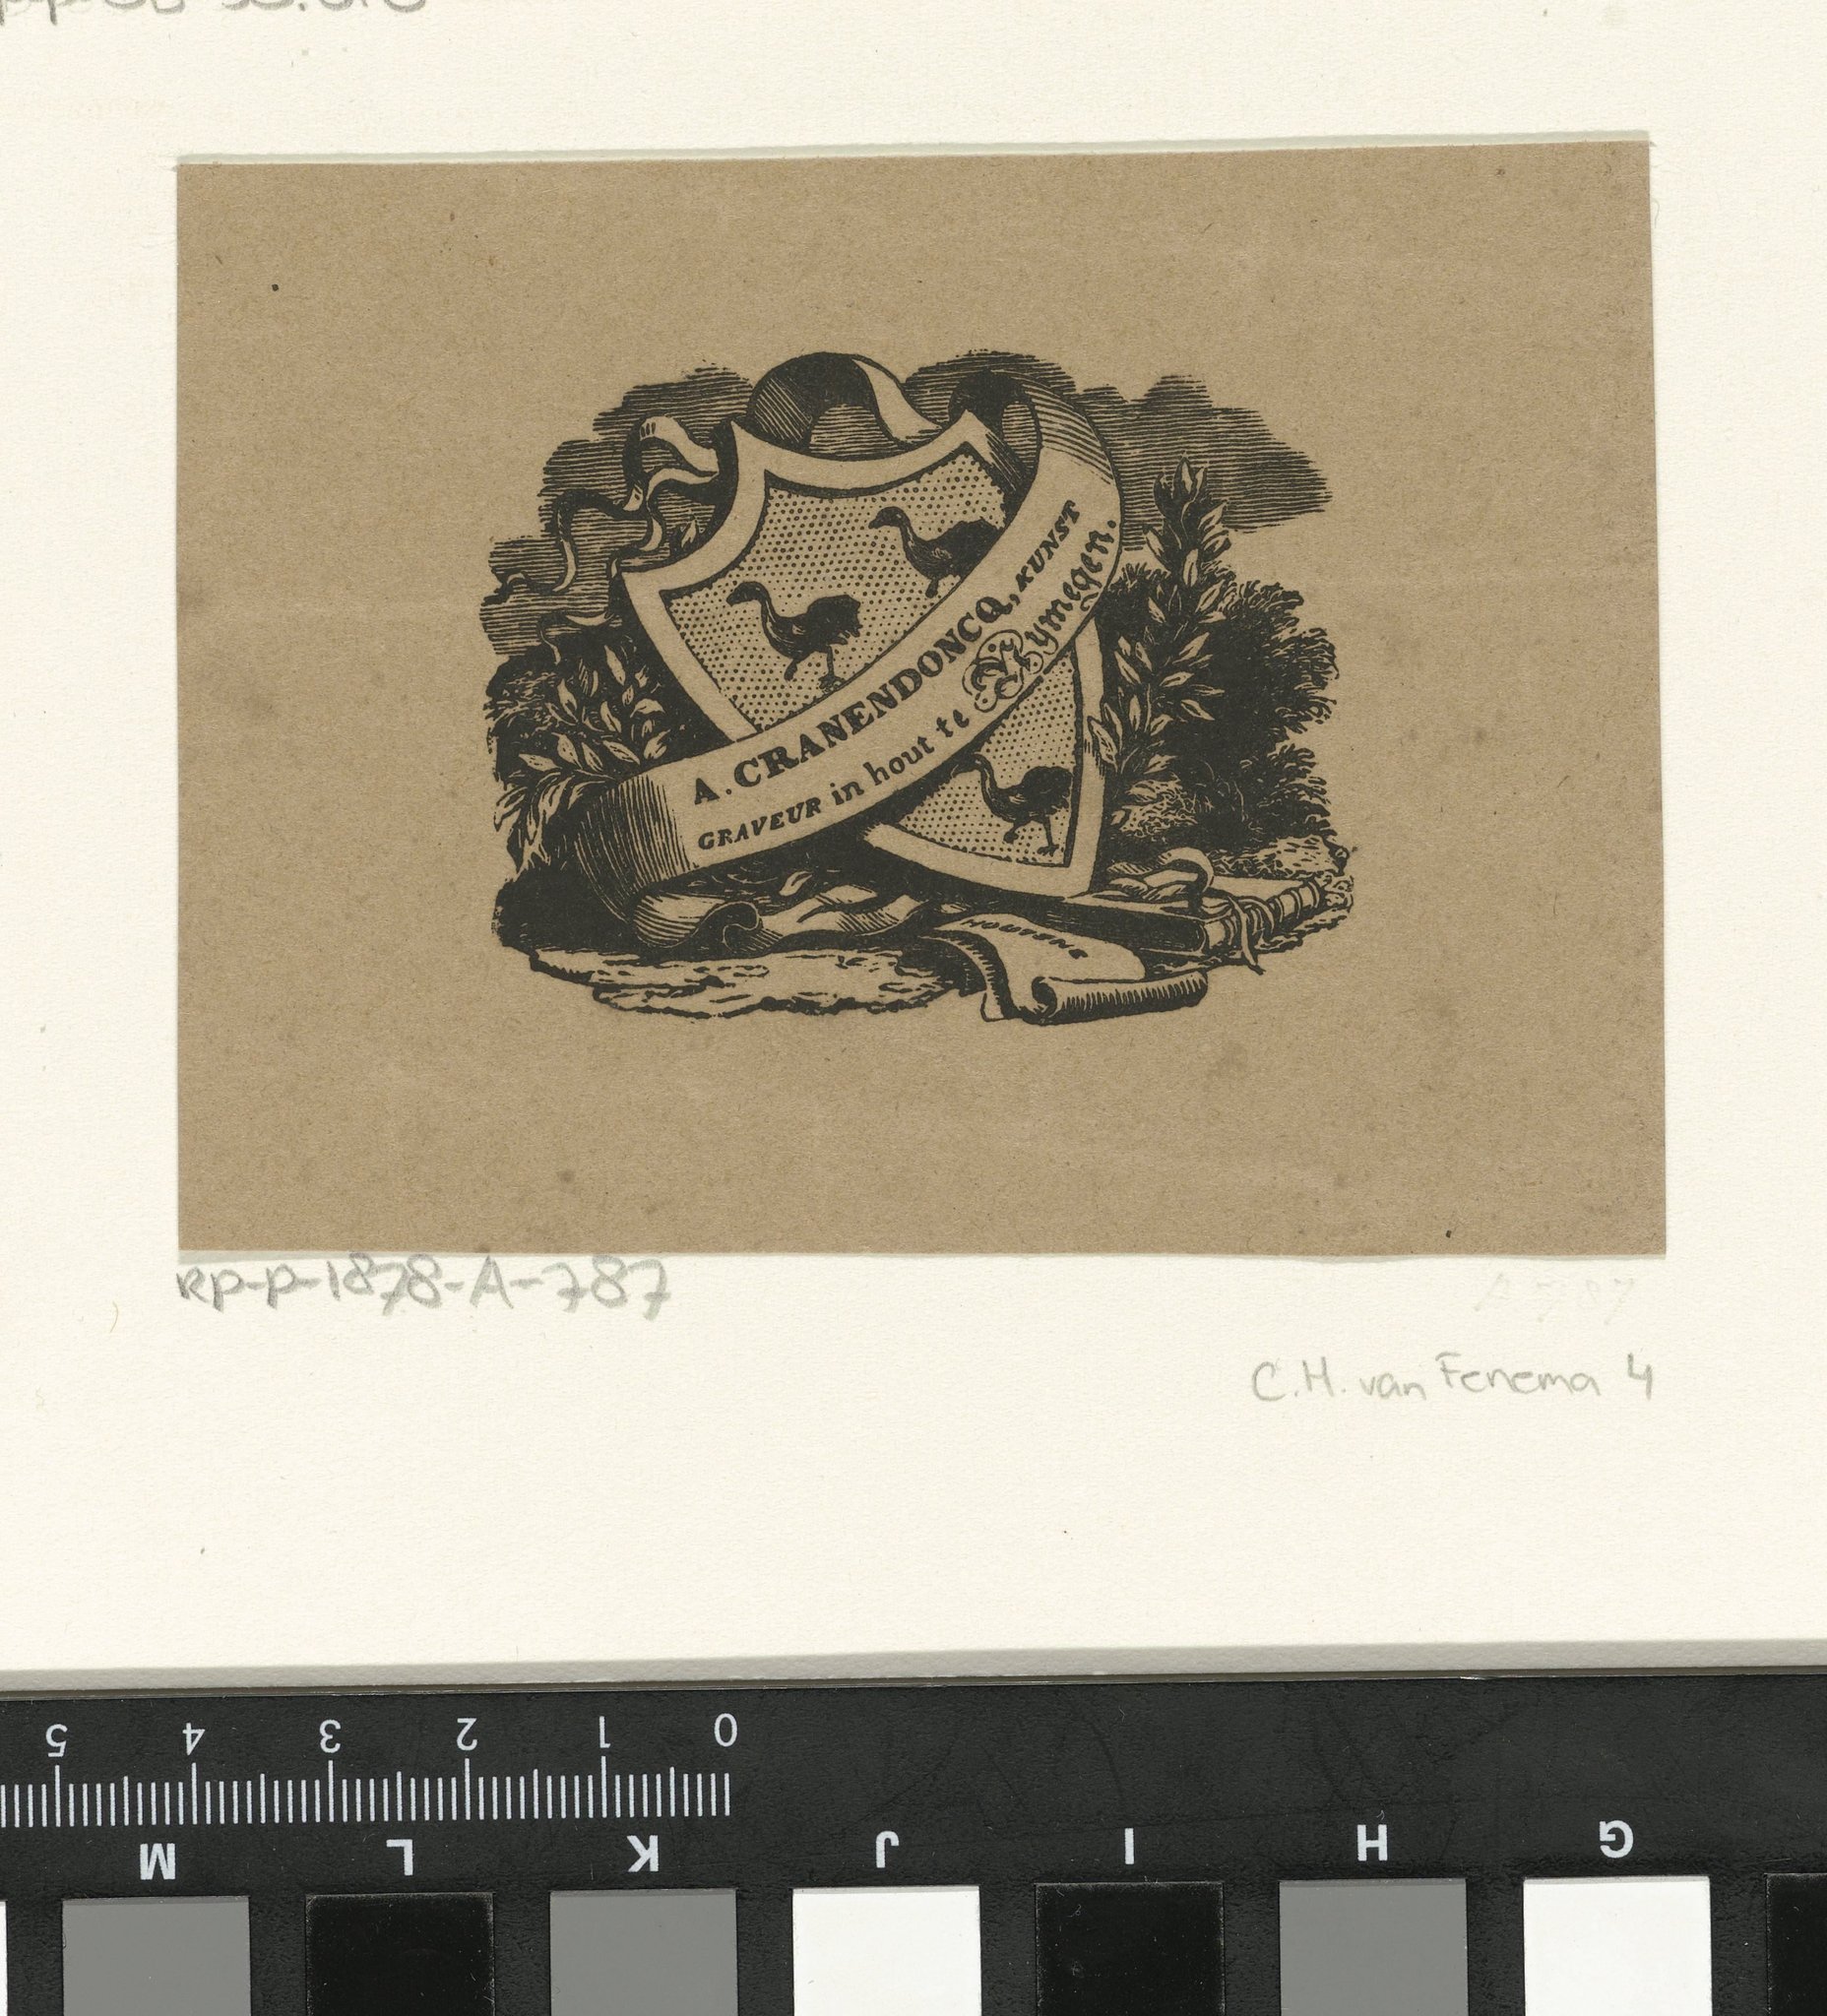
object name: print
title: Wapen van de familie Cranendoncq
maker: alexander cranendoncq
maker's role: draughtsman, print maker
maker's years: 1799-1869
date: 1809-1869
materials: paper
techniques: engraving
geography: nijmegen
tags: shore-birds and wading-birds: crane, armorial bearing, heraldry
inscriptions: collector's mark: Lugt 2228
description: Wapen met drie kraanvogels en een banderol met de tekst 'A. Cranendoncq, kunst graveur in hout te Nijmegen'.